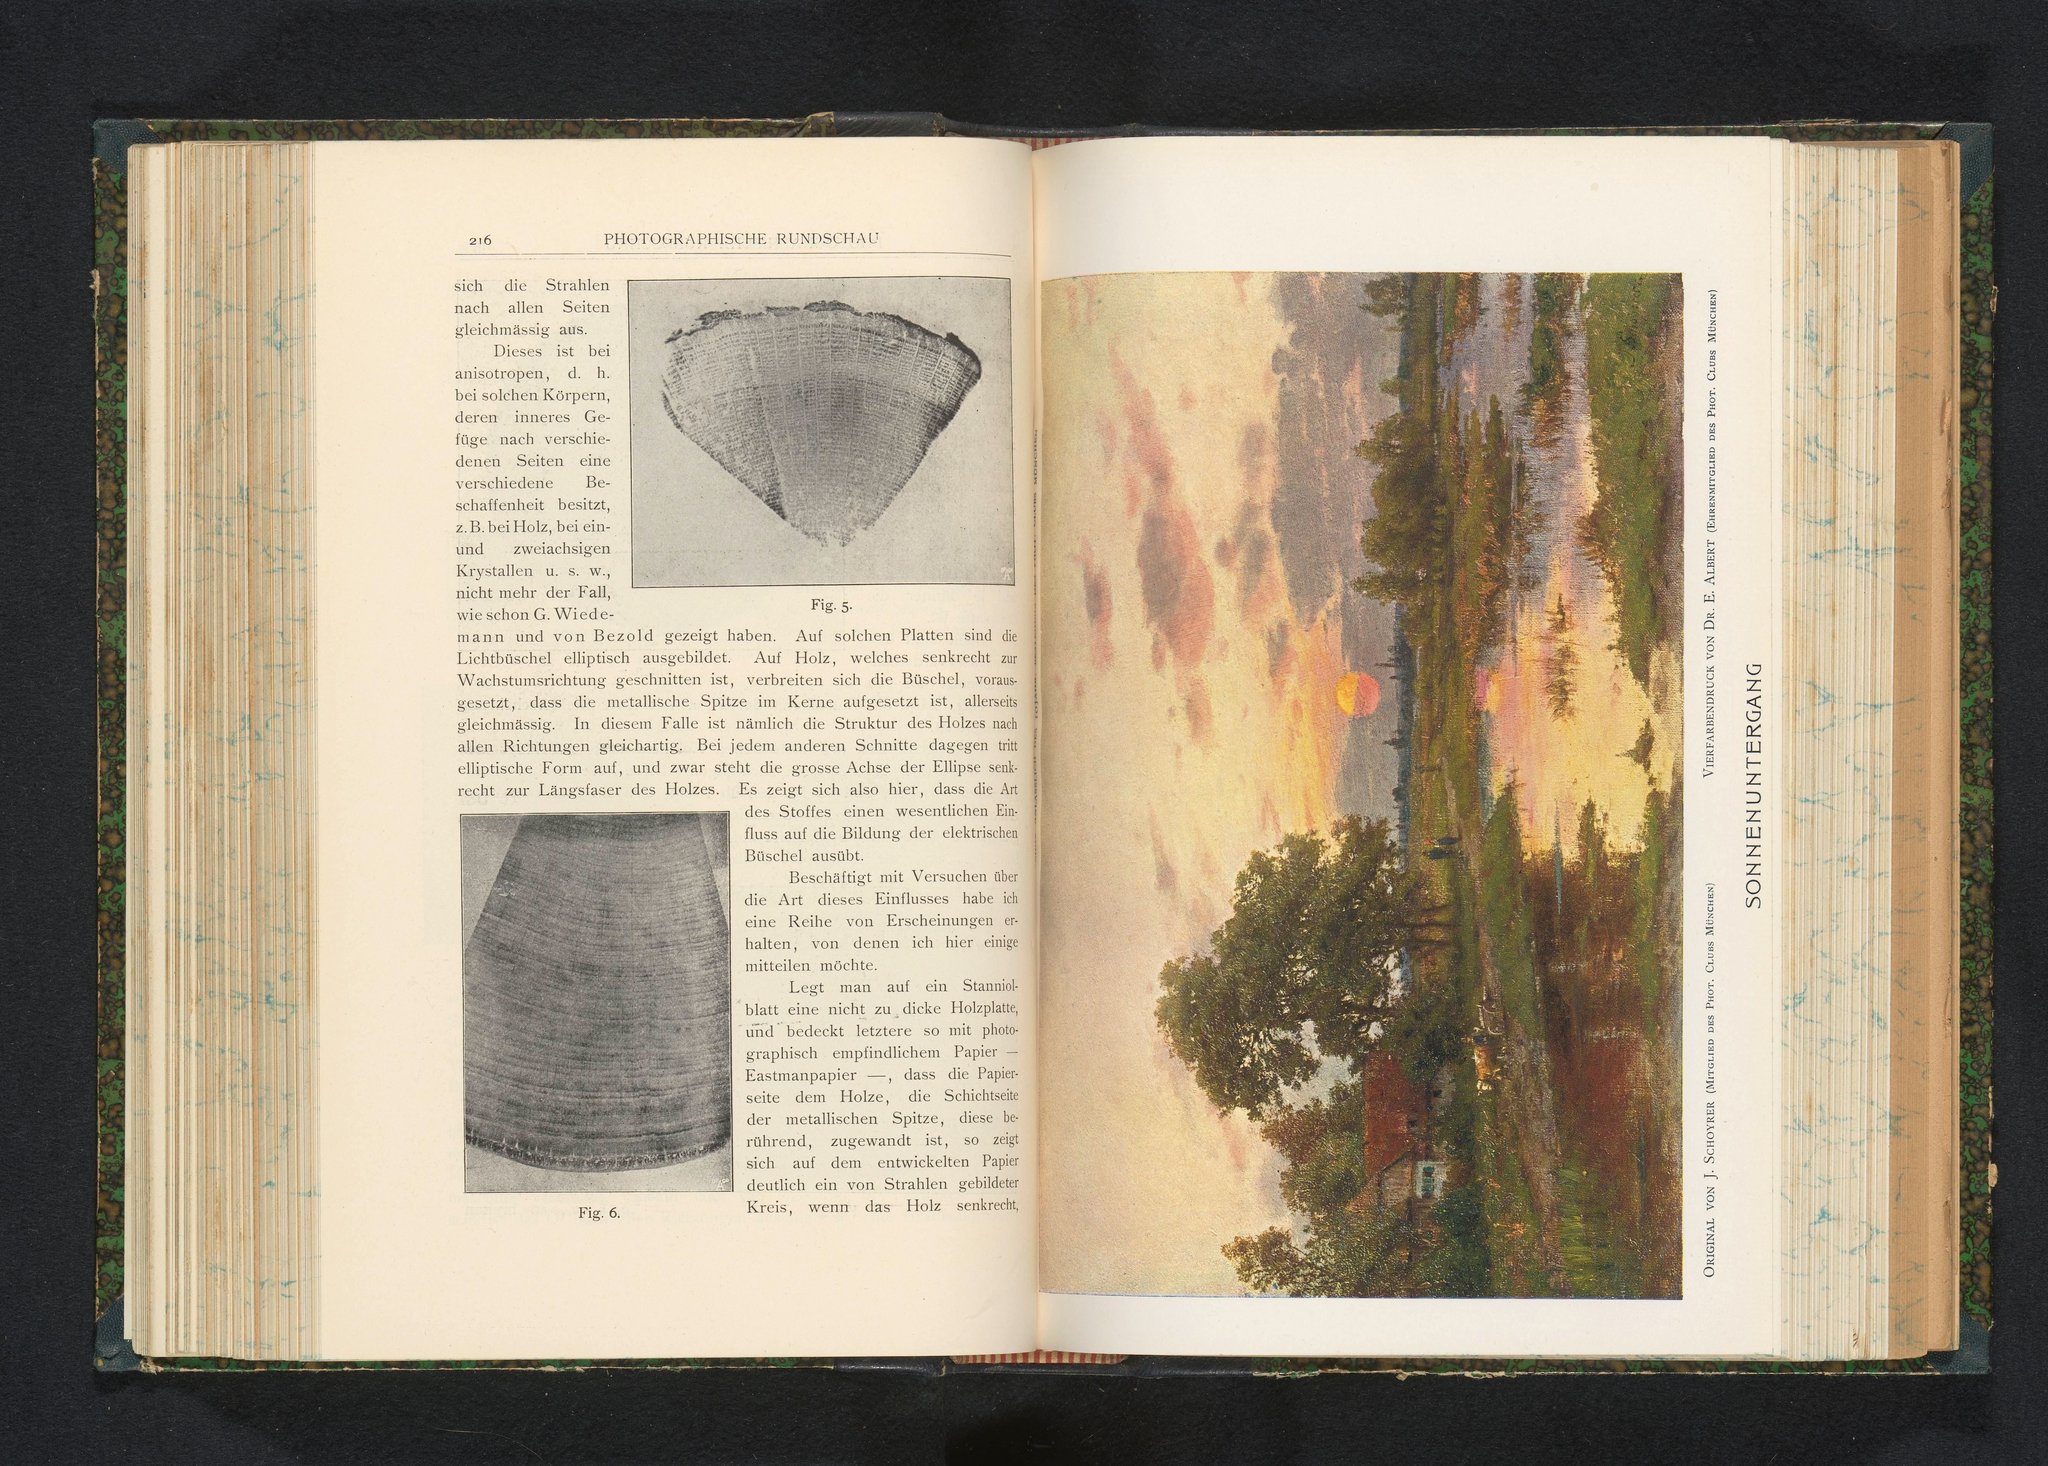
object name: page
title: Sonnenuntergang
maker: j. schoyrer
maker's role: fotograaf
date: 1894-1899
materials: paper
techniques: four-color autotype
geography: munich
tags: landscapes, sunset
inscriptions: inscription: ‘Beilage zur Festnummer der Phot. Rundschau anlässlich des 10Jähr. Bestehens des Phot. Clubs München’